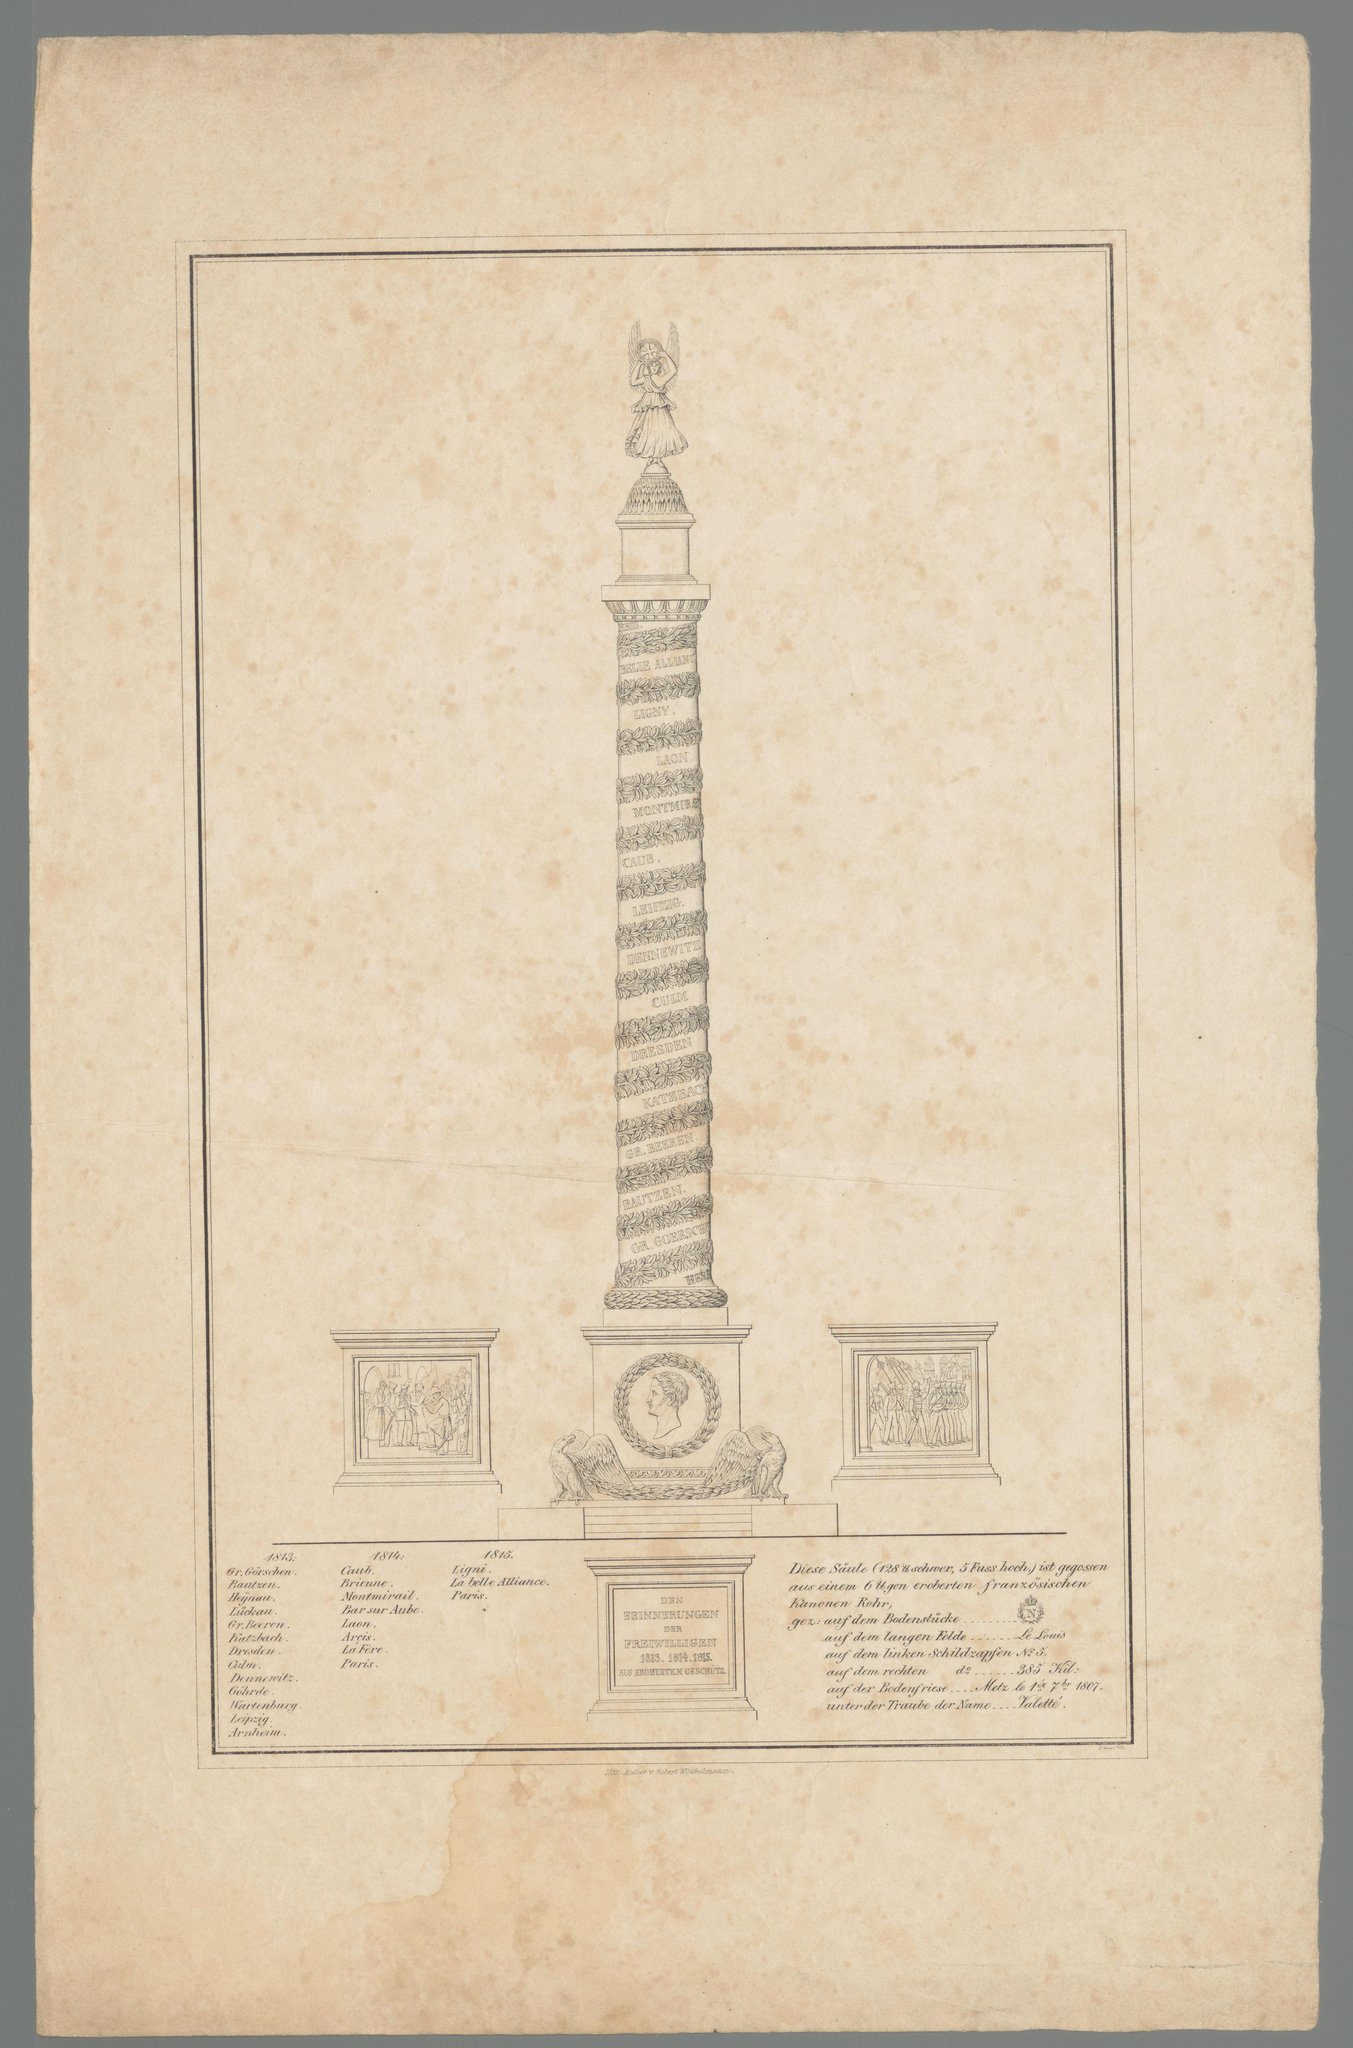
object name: print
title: Herinneringsobelisk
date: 1815-1850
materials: paper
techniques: lithograph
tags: obelisk, needle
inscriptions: collector's mark: Lugt 2228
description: Obelisk met herinneringen aan de vrijwilligers in 1813-1815 aan de hand van buitgemaakte wapens.